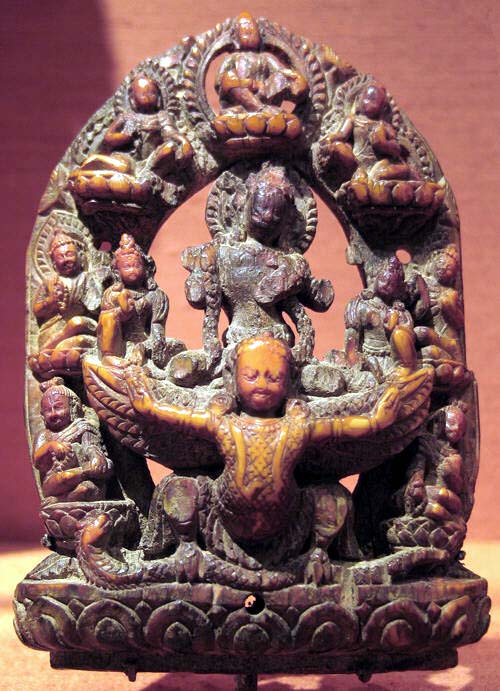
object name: plaque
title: Vishnu on Garuda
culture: nepali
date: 1401-1500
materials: ivory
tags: vishnu,hinduism